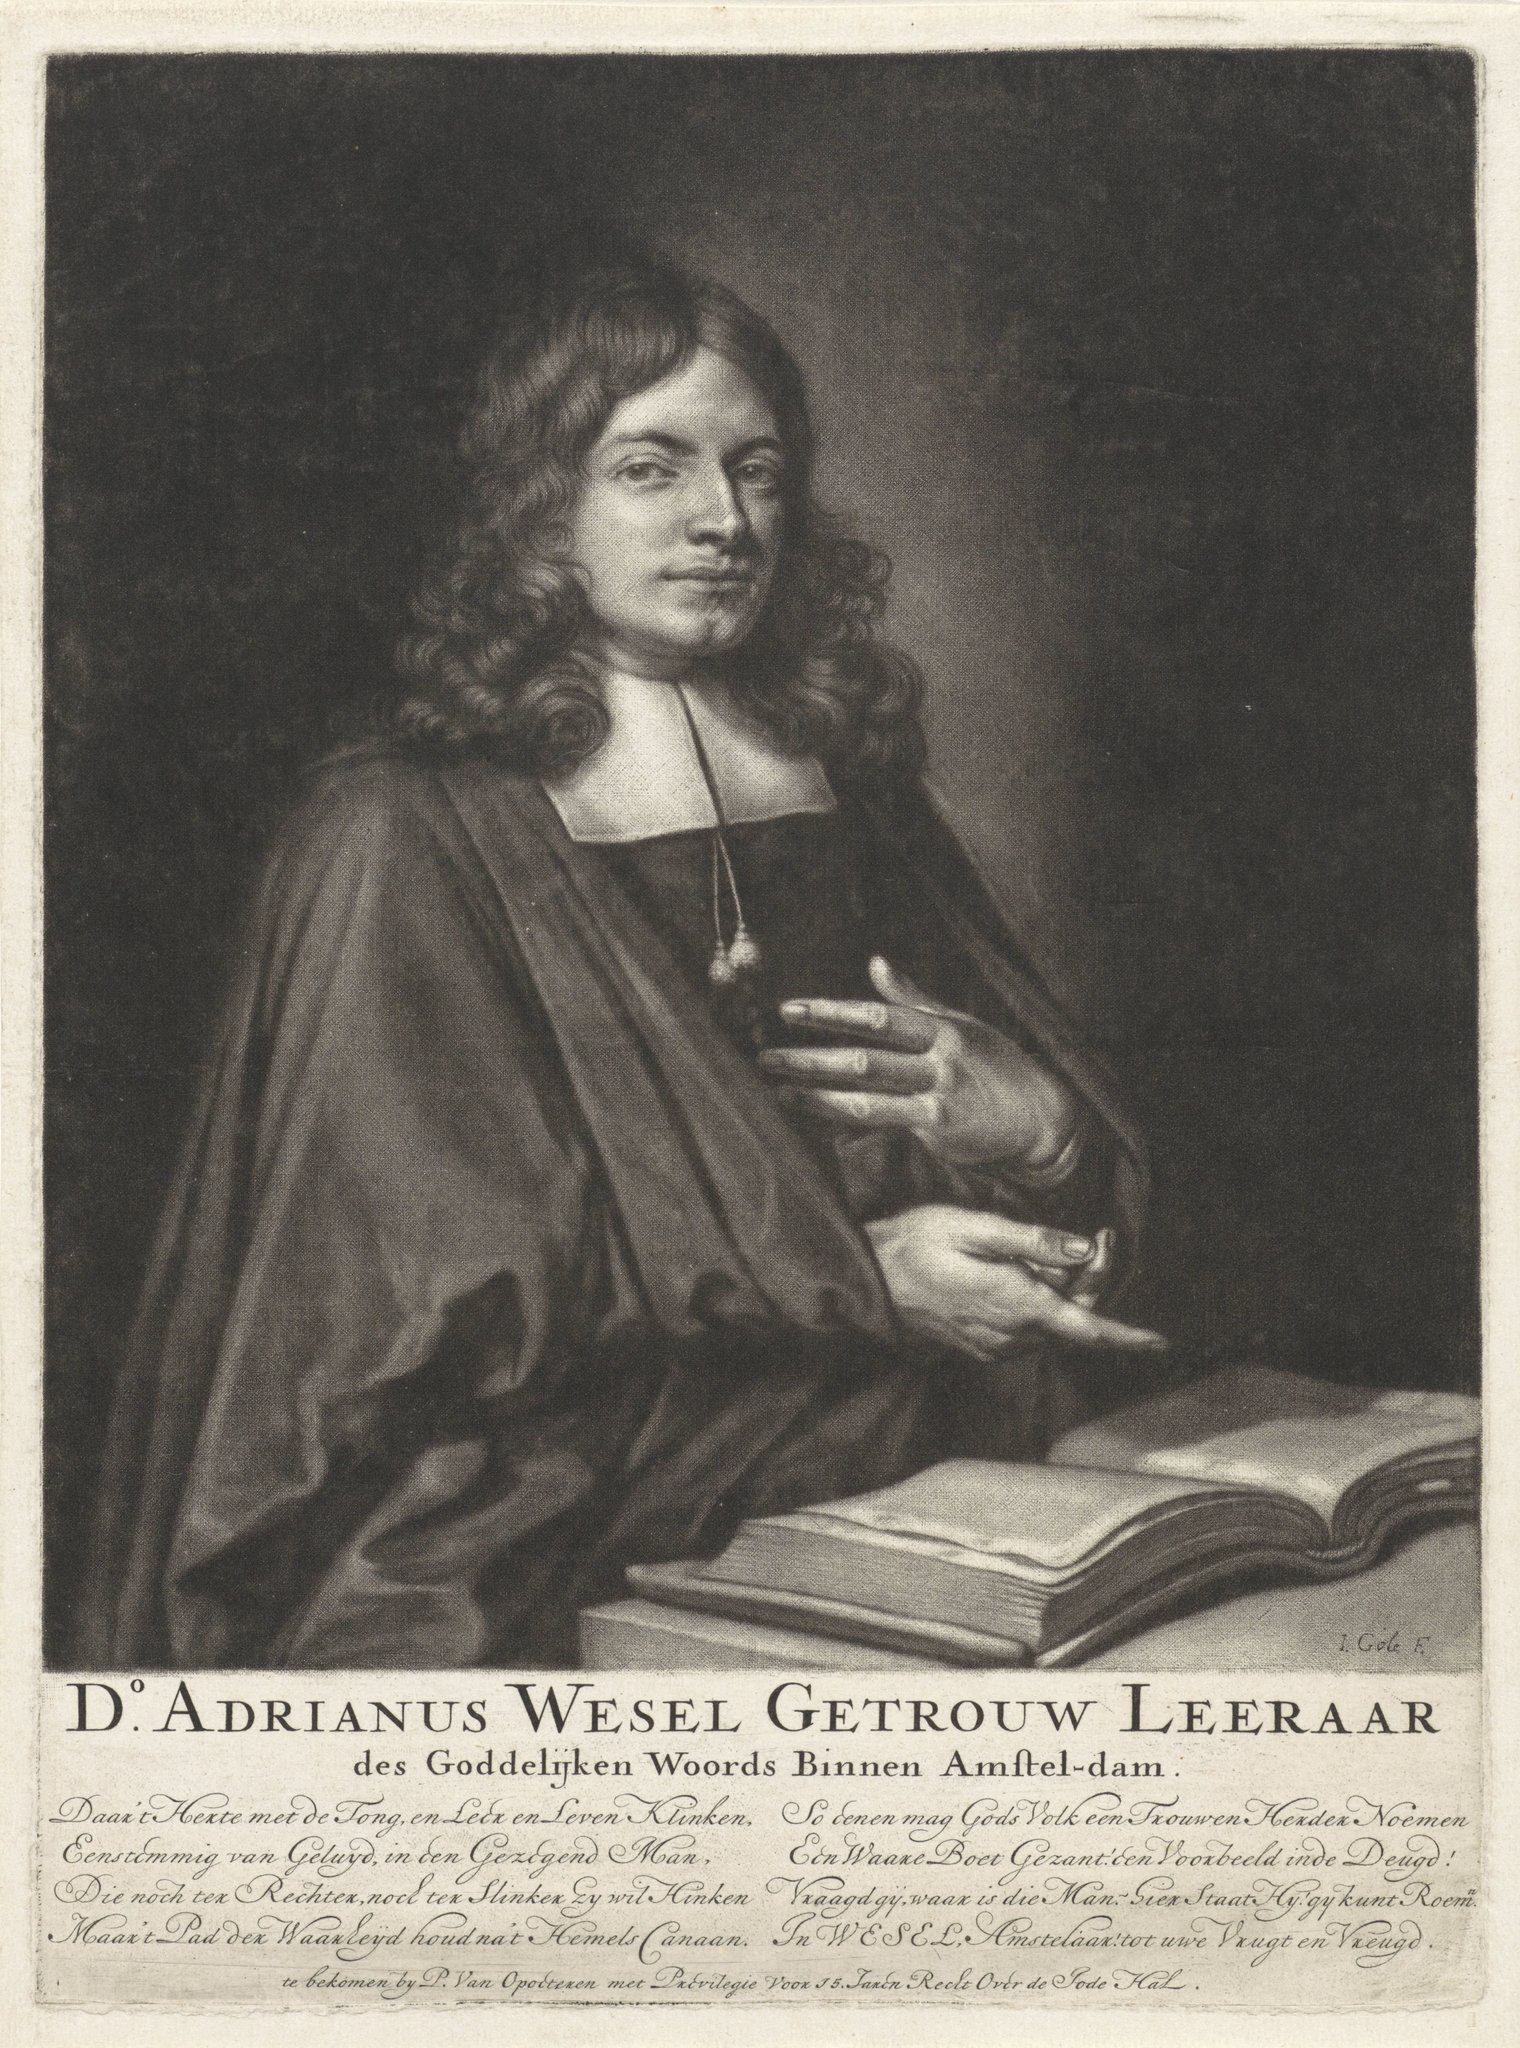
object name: print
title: Portret van Adriaan Wesel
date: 1685-1724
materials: paper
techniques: engraving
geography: amsterdam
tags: adriaan wesel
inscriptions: collector's mark: Lugt 2228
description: Adriaan Wesel, wijzend op een opengeslagen boek. Hij was predikant in verschillende steden, waaronder Amsterdam.